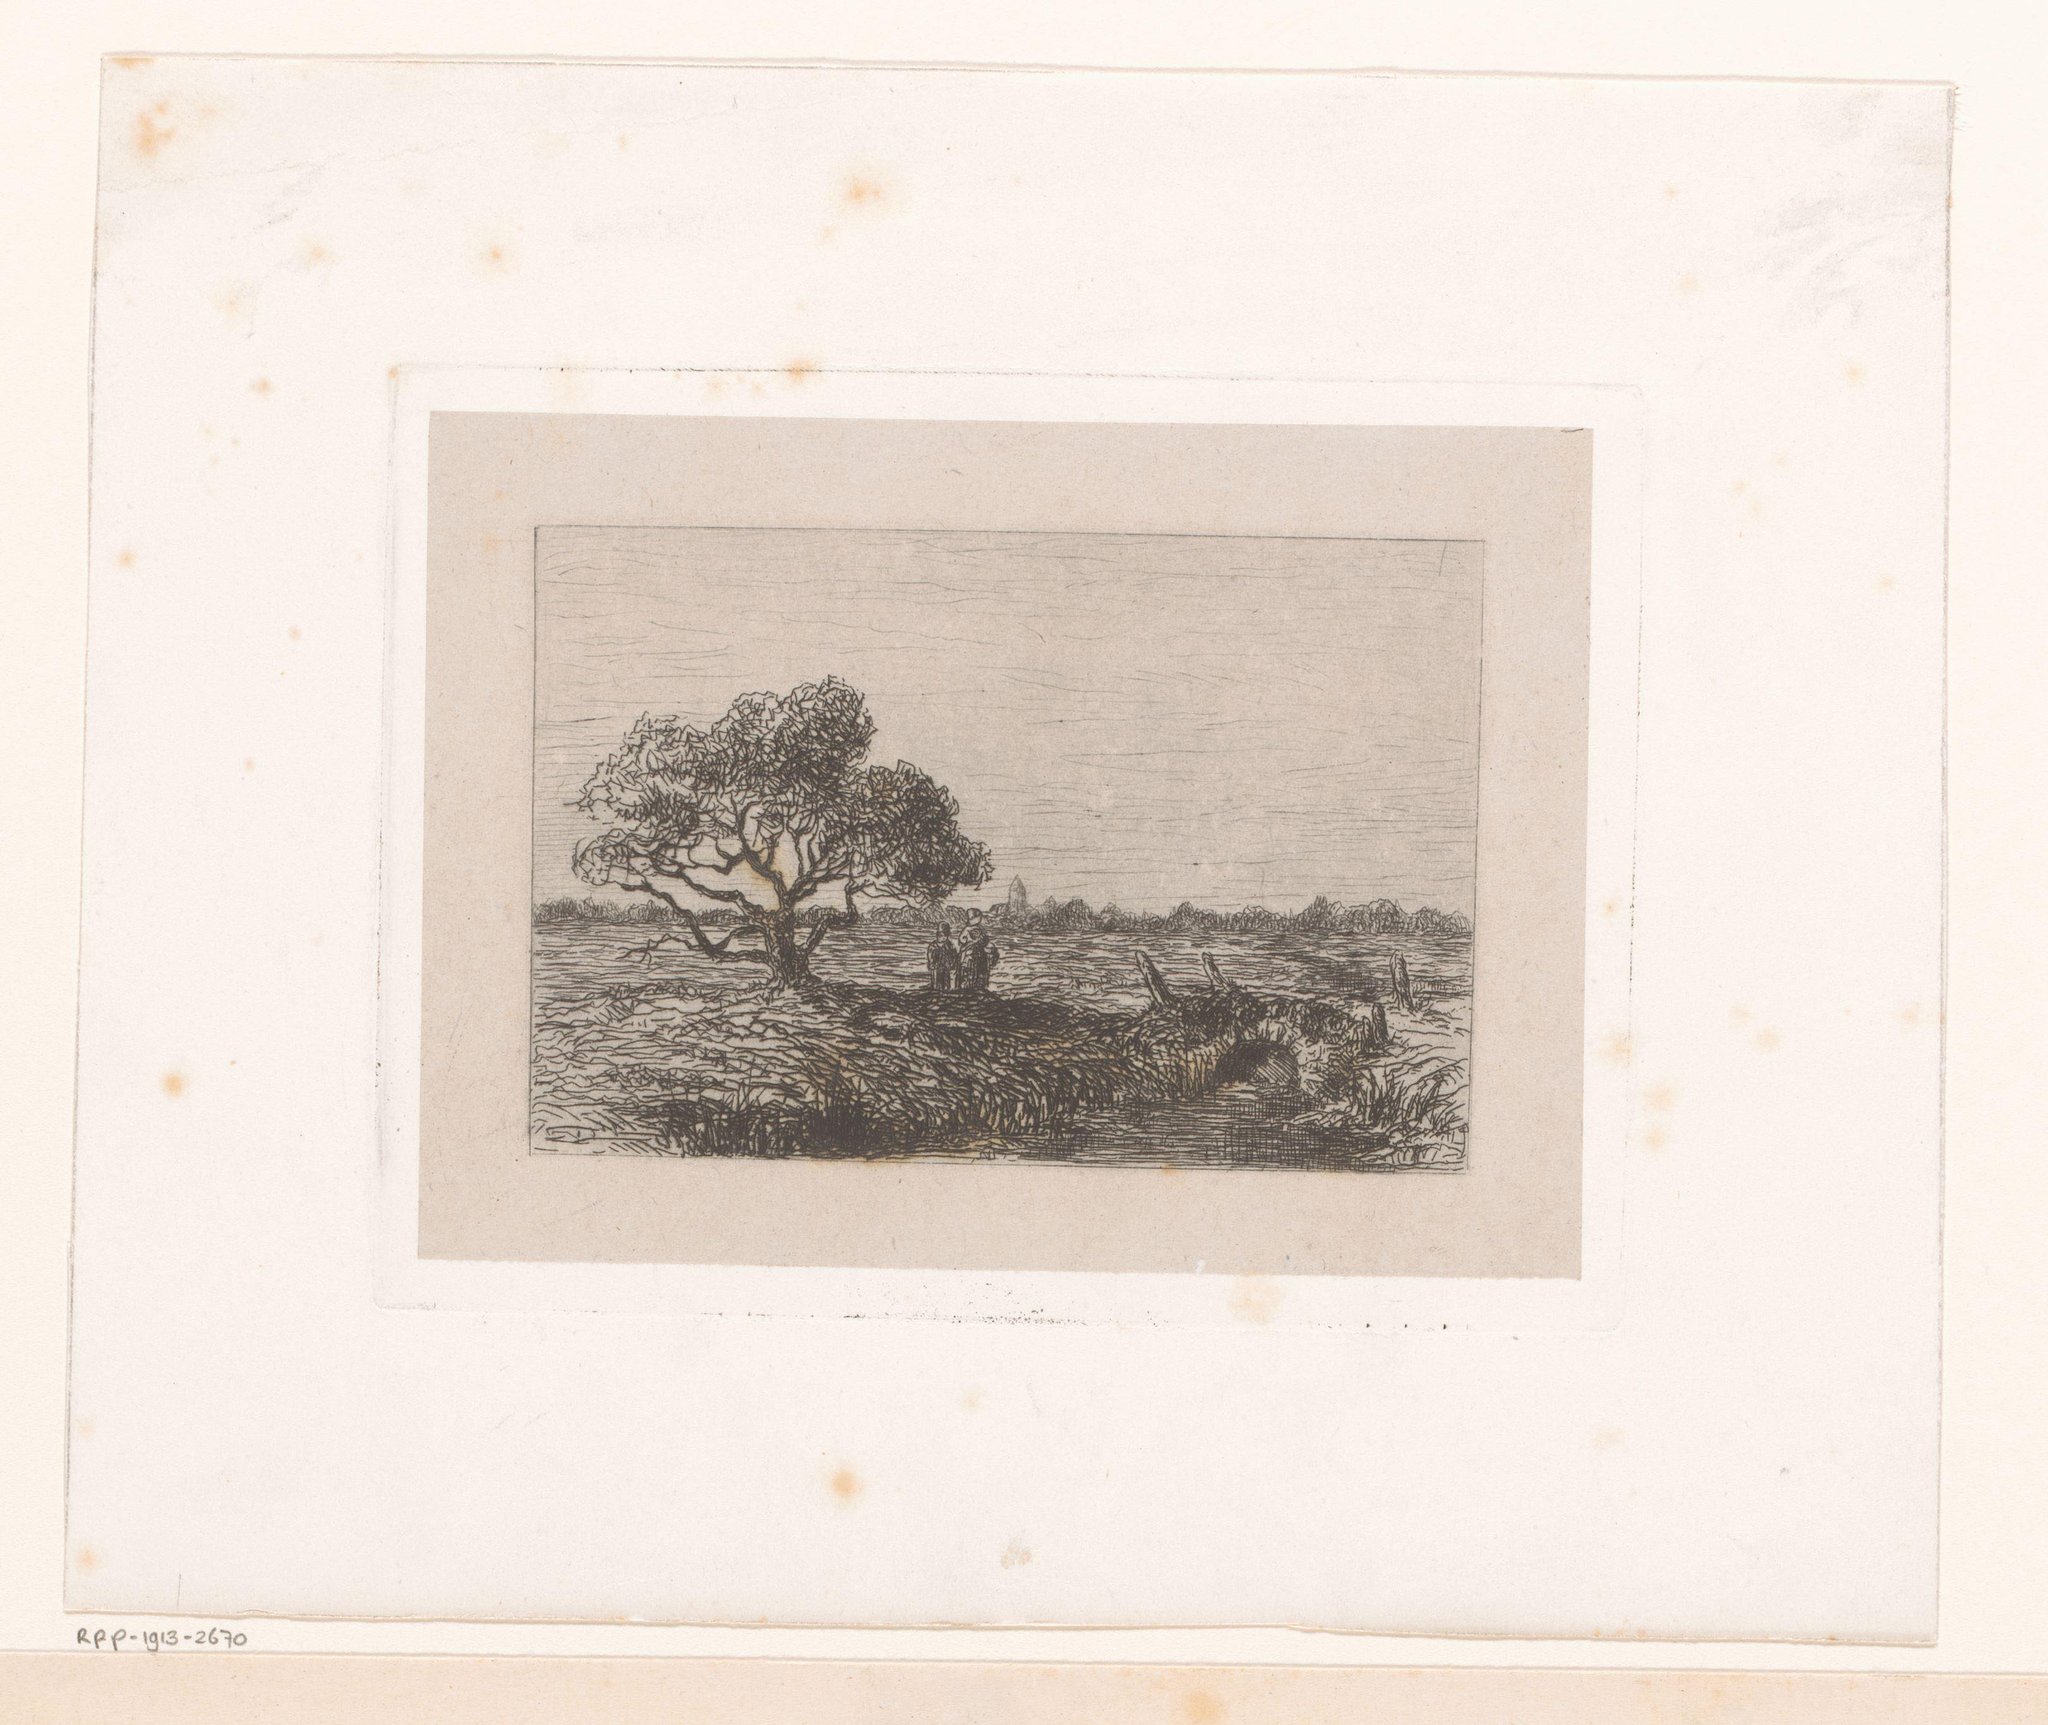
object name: print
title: Gezicht op de Kempen met boom en twee figuren bij een brug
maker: emilie rolin-jacquemijns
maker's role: print maker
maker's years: 1842-1906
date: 1852-1906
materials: paper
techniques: etching, retroussage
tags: trees, bridge, landscapes (+ landscape with figures, staffage)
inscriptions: collector's mark: Lugt 2228